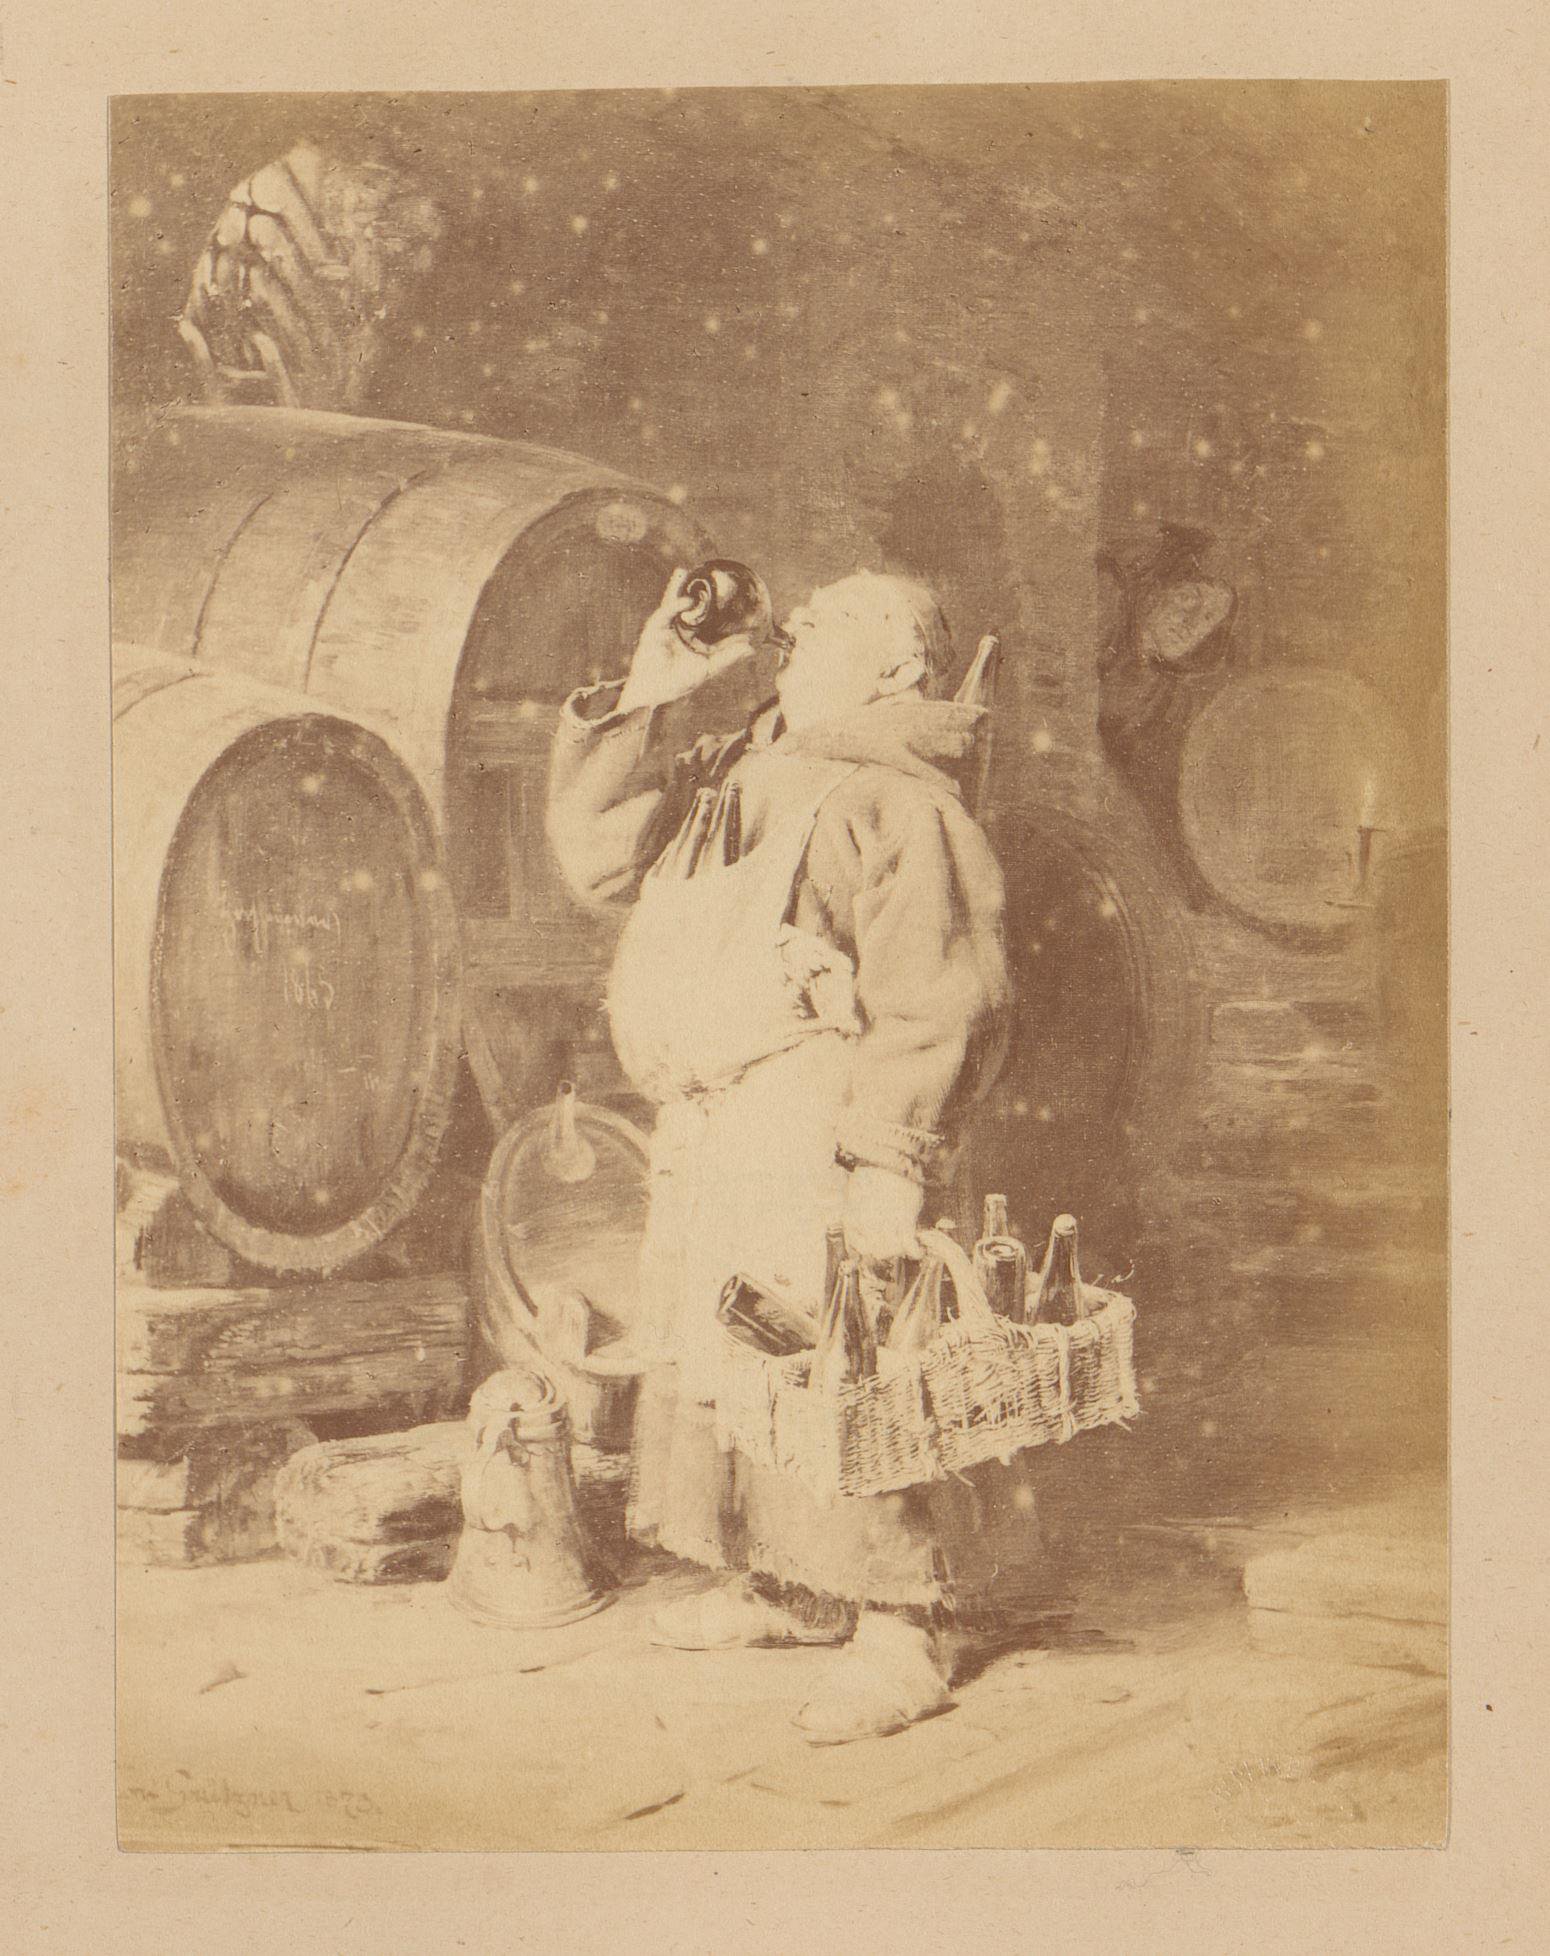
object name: photograph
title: Fotoreproductie van een schilderij met een drinkende monnik met lege flessen in een wijnkelder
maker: Anonymous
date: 1875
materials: paper, photographic support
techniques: albumen print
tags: wine-vault, 'cave', monk(s), friar(s)